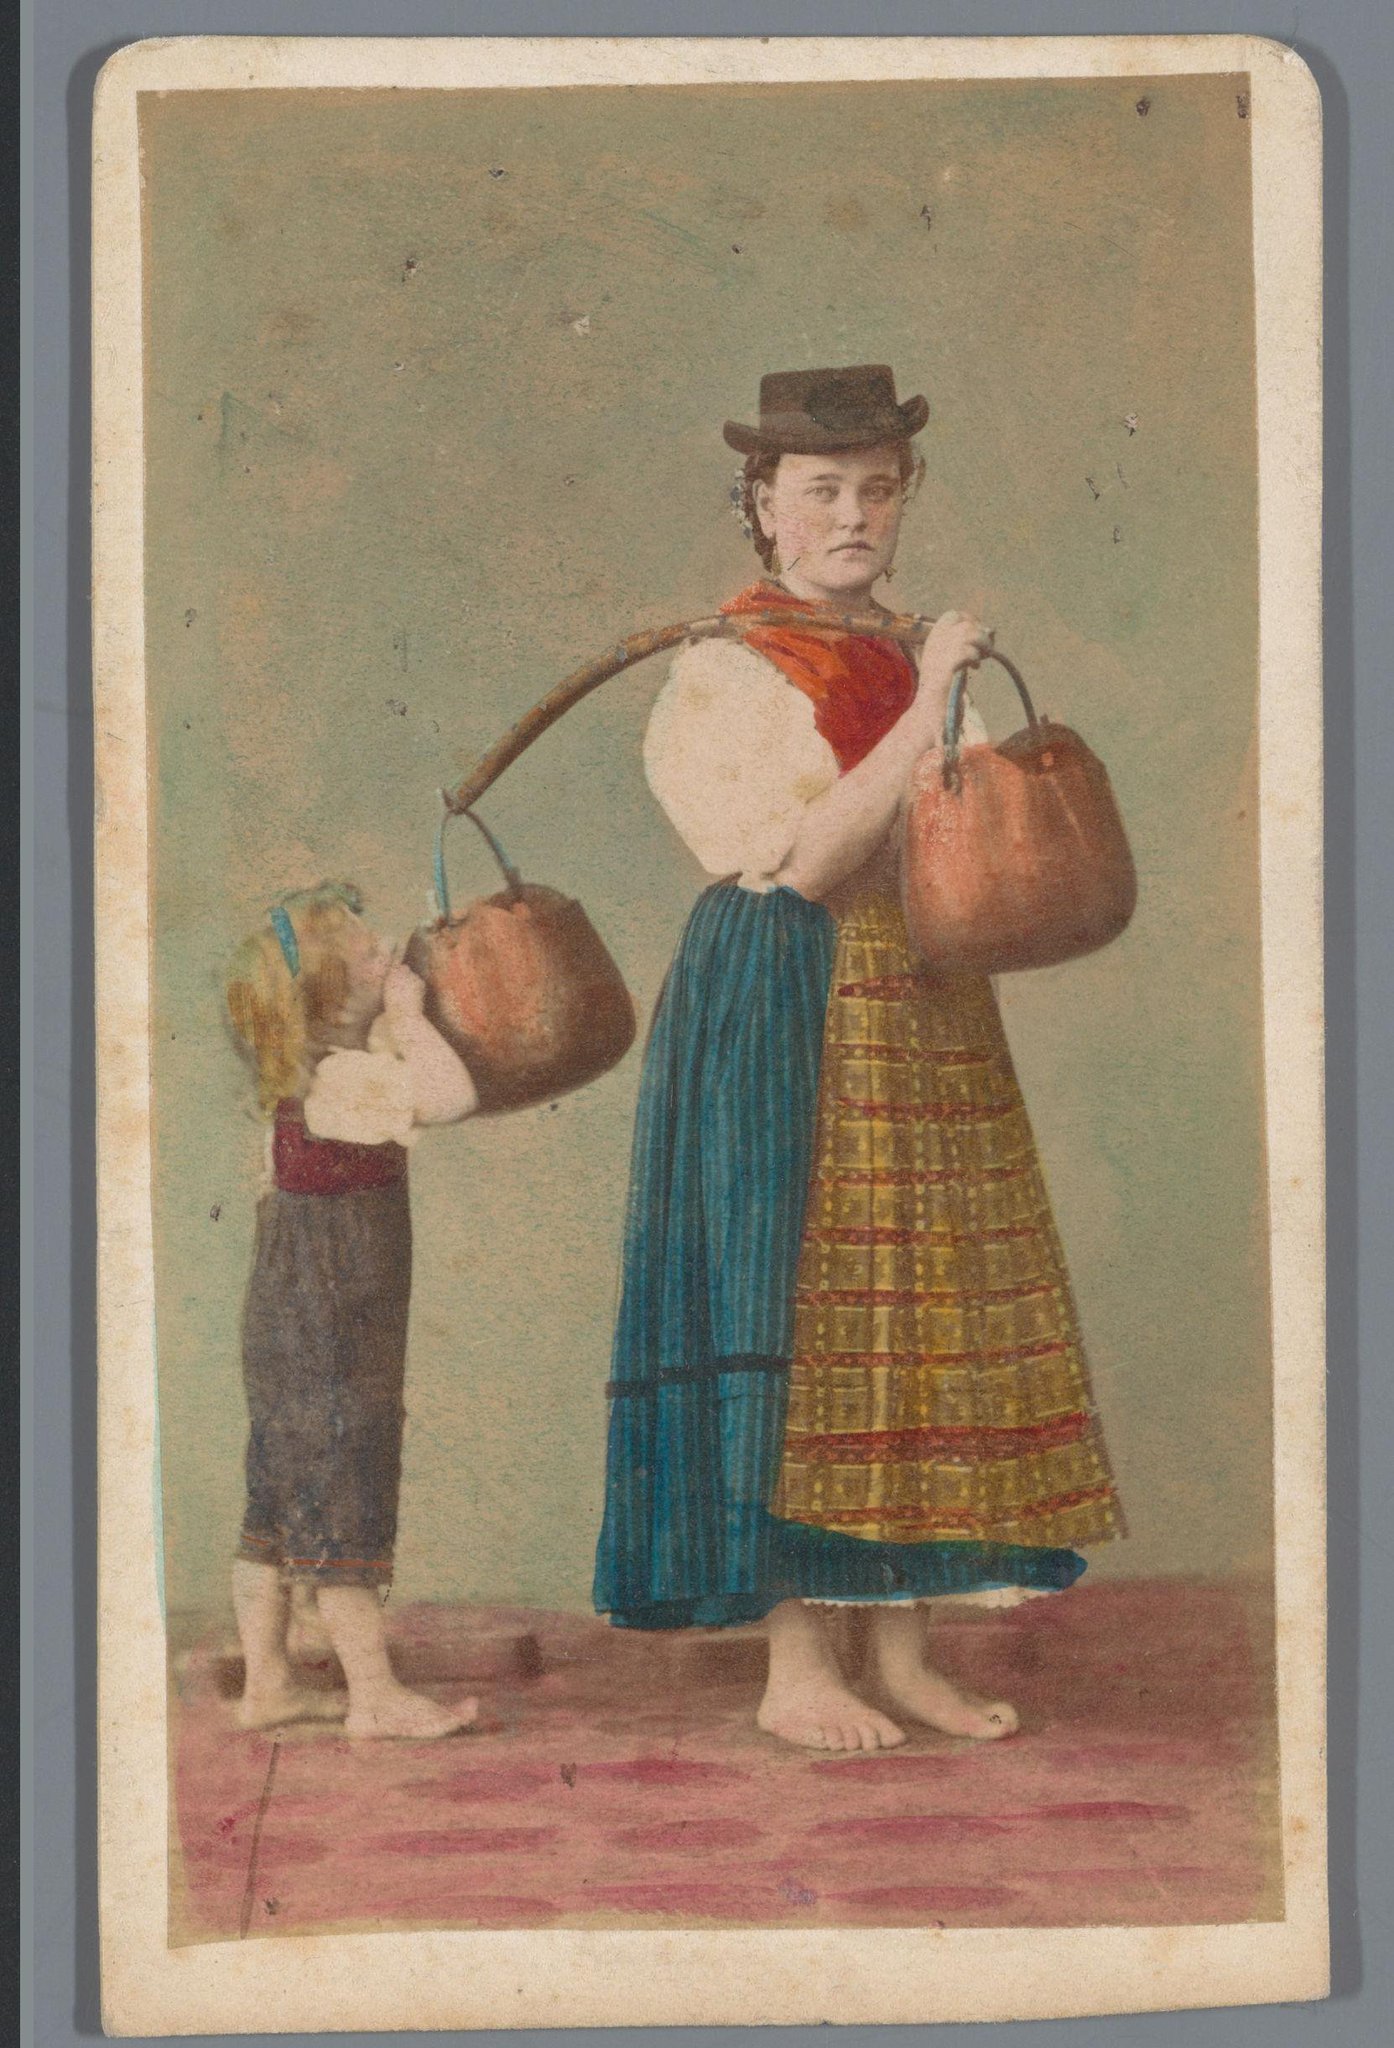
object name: photograph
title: Portret van een onbekende vrouw in lokale dracht met koperen wateremmers, een kind kijkt in een van de emmers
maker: Anonymous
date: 1854-1885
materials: cardboard, paper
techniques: albumen print, hand coloring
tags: anonymous historical person portrayed, folk costume, regional costume, container of metal: bucket, can, canister, drum, tin